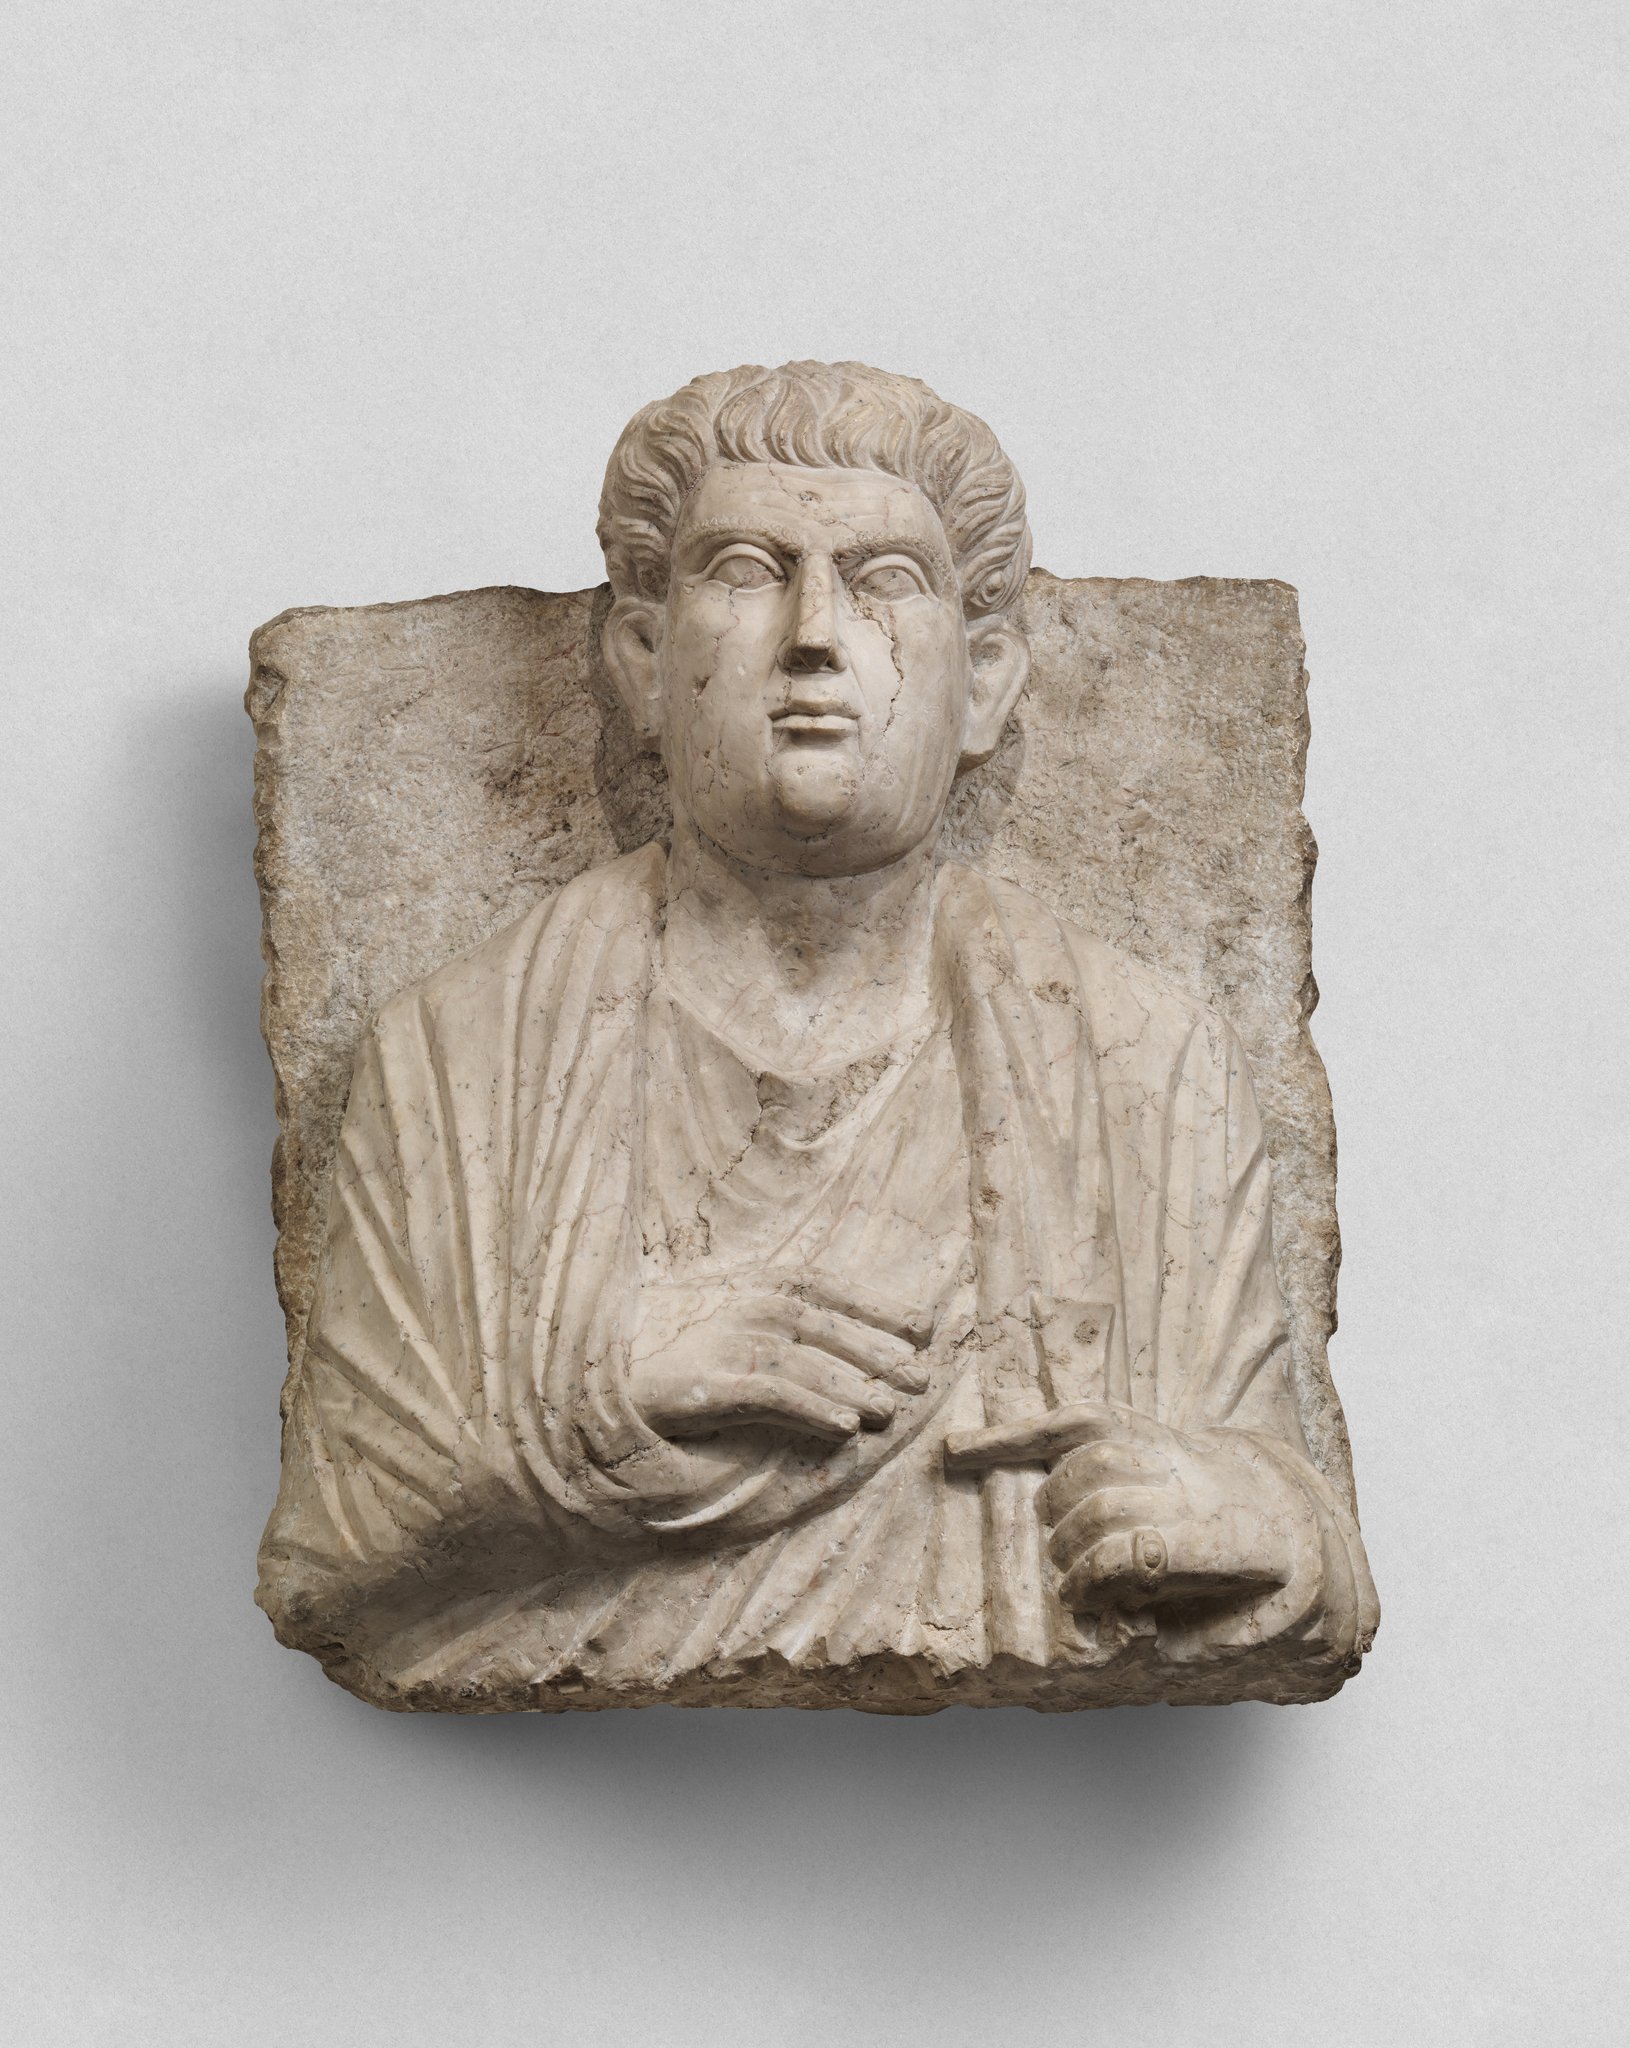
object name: funerary relief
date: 150-200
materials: limestone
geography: syria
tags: men